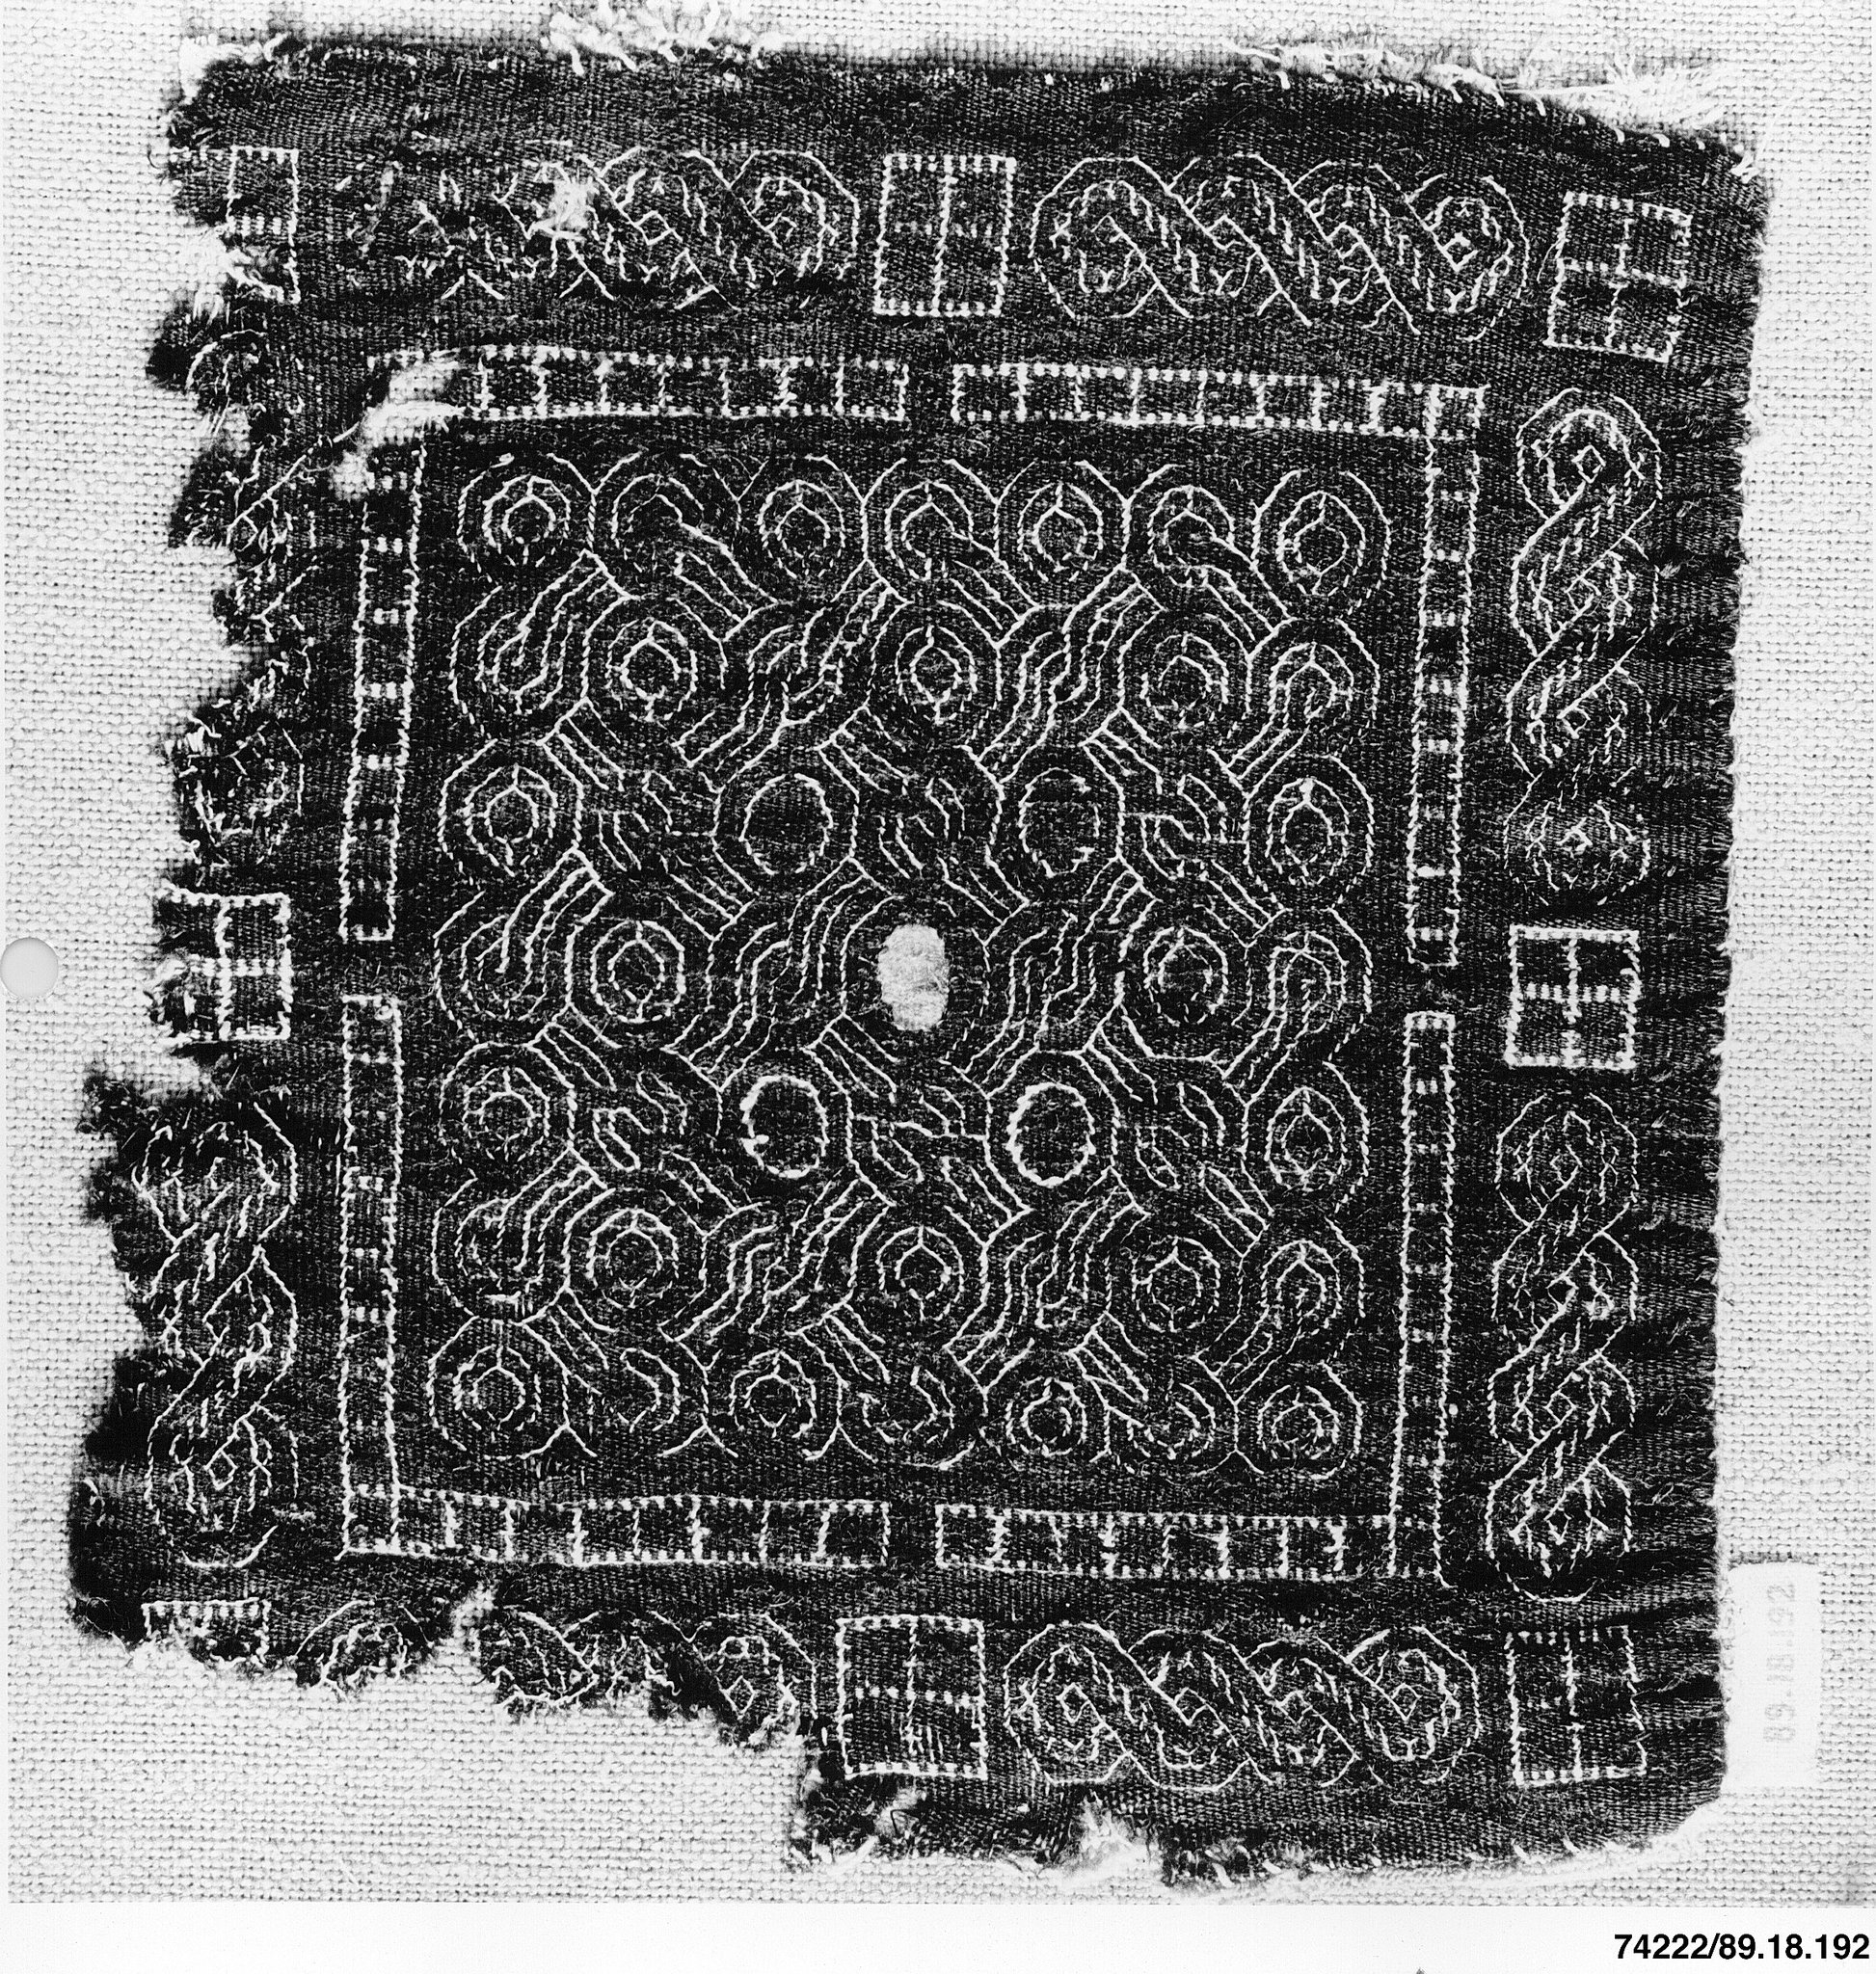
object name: textile fragment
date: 201-400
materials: linen, wool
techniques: weave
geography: egypt